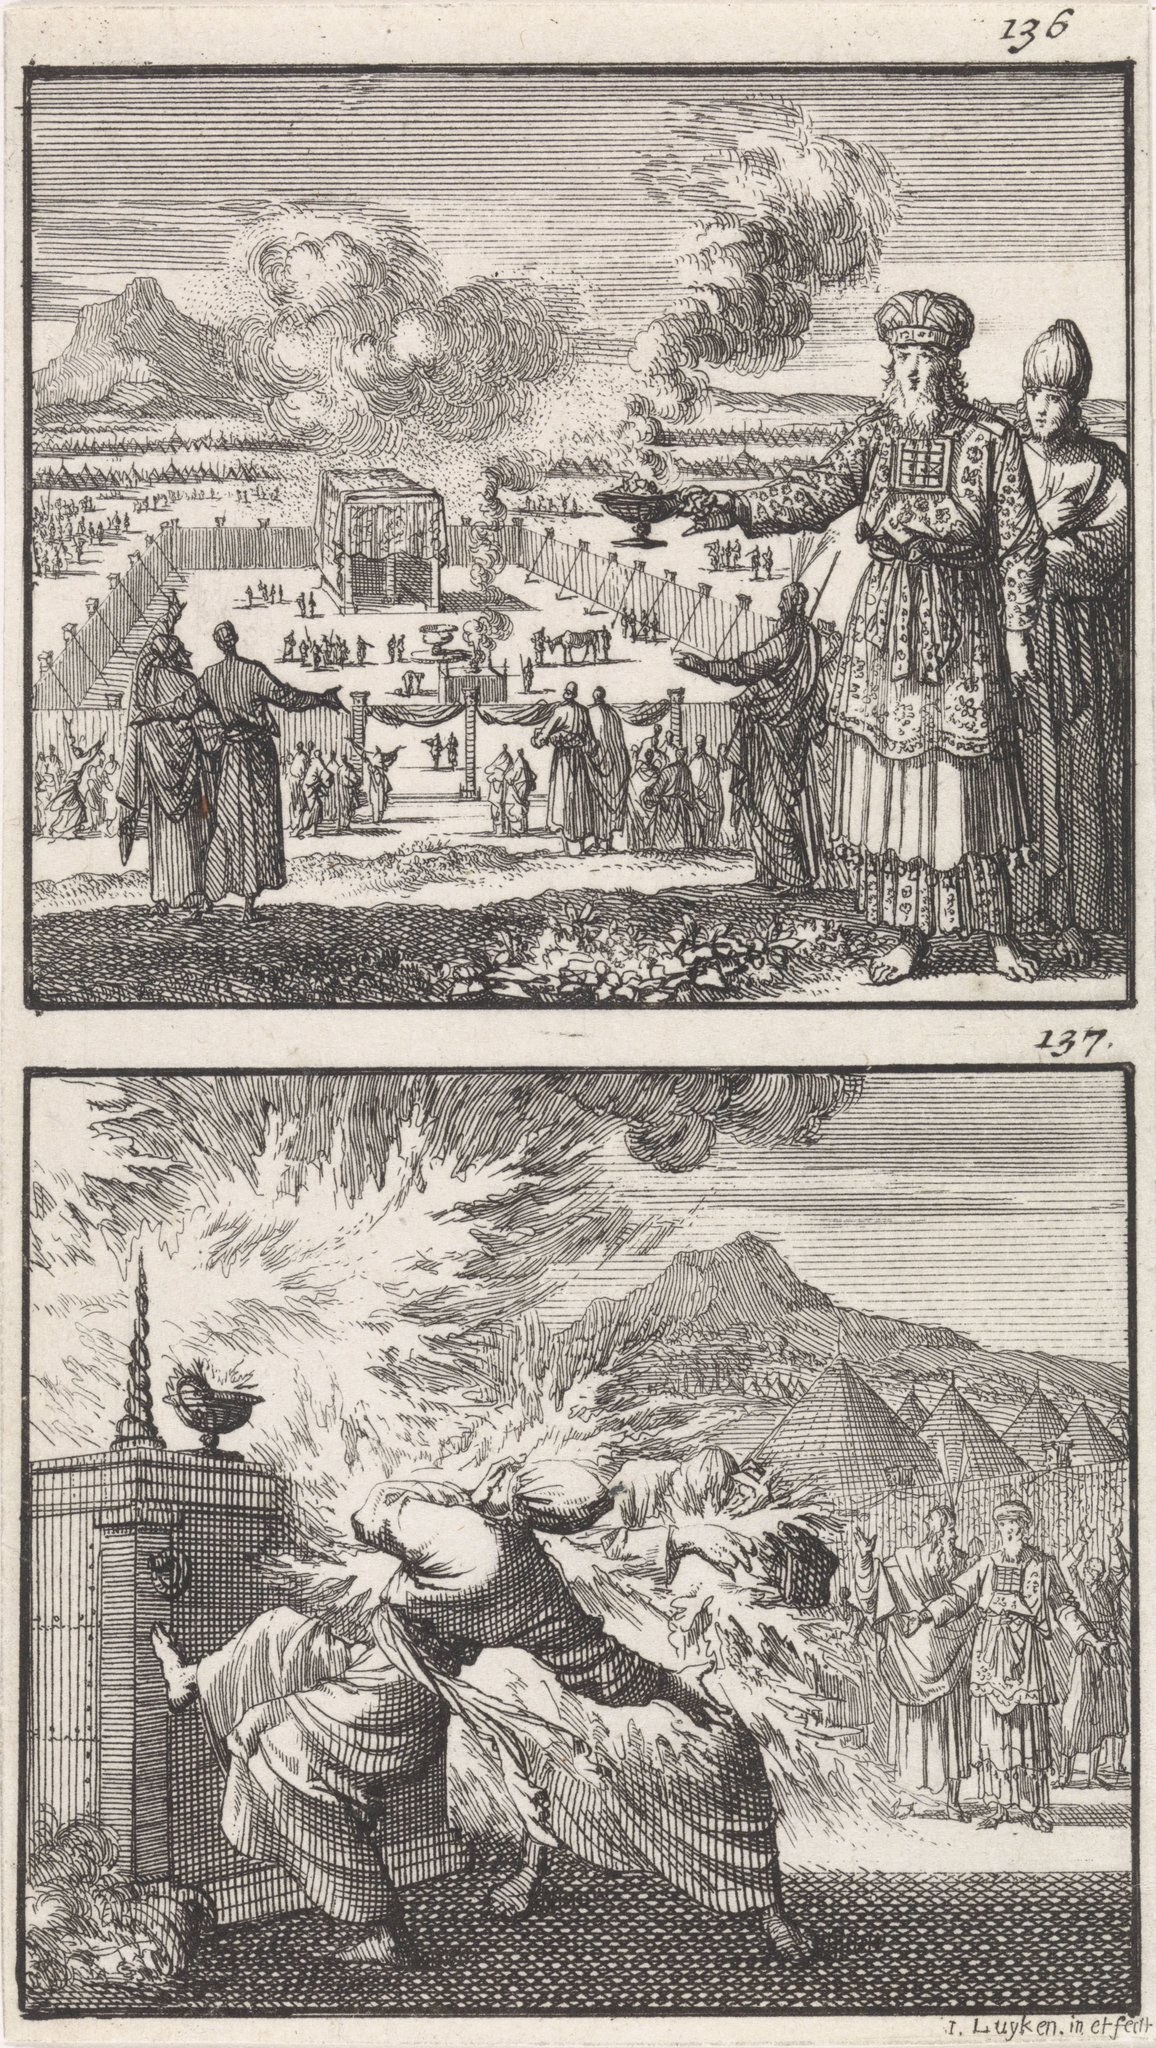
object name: print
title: Aäron als hogepriester / Nadab en Abihu bij het altaar gedood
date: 1698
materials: paper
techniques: etching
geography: amsterdam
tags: two sons of aaron, nadab and abihu, offer incense in their censers to god, who punishes them for this by sending a fire that kills them, aaron (not in biblical context); possible attributes: attributes of aaron: censer, dressed as high priest or bishop, ointment jar, rod or flowering wand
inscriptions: collector's mark: Lugt 2228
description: Illustratie uit: Josephus, Flavius. XX. boeken van de oude geschiedenissen der joden, 4 delen. Amsterdam: Barent Visscher, Willem de Coup, Willem van Lamsveld, Andries van Damme, 1698, dl. I.